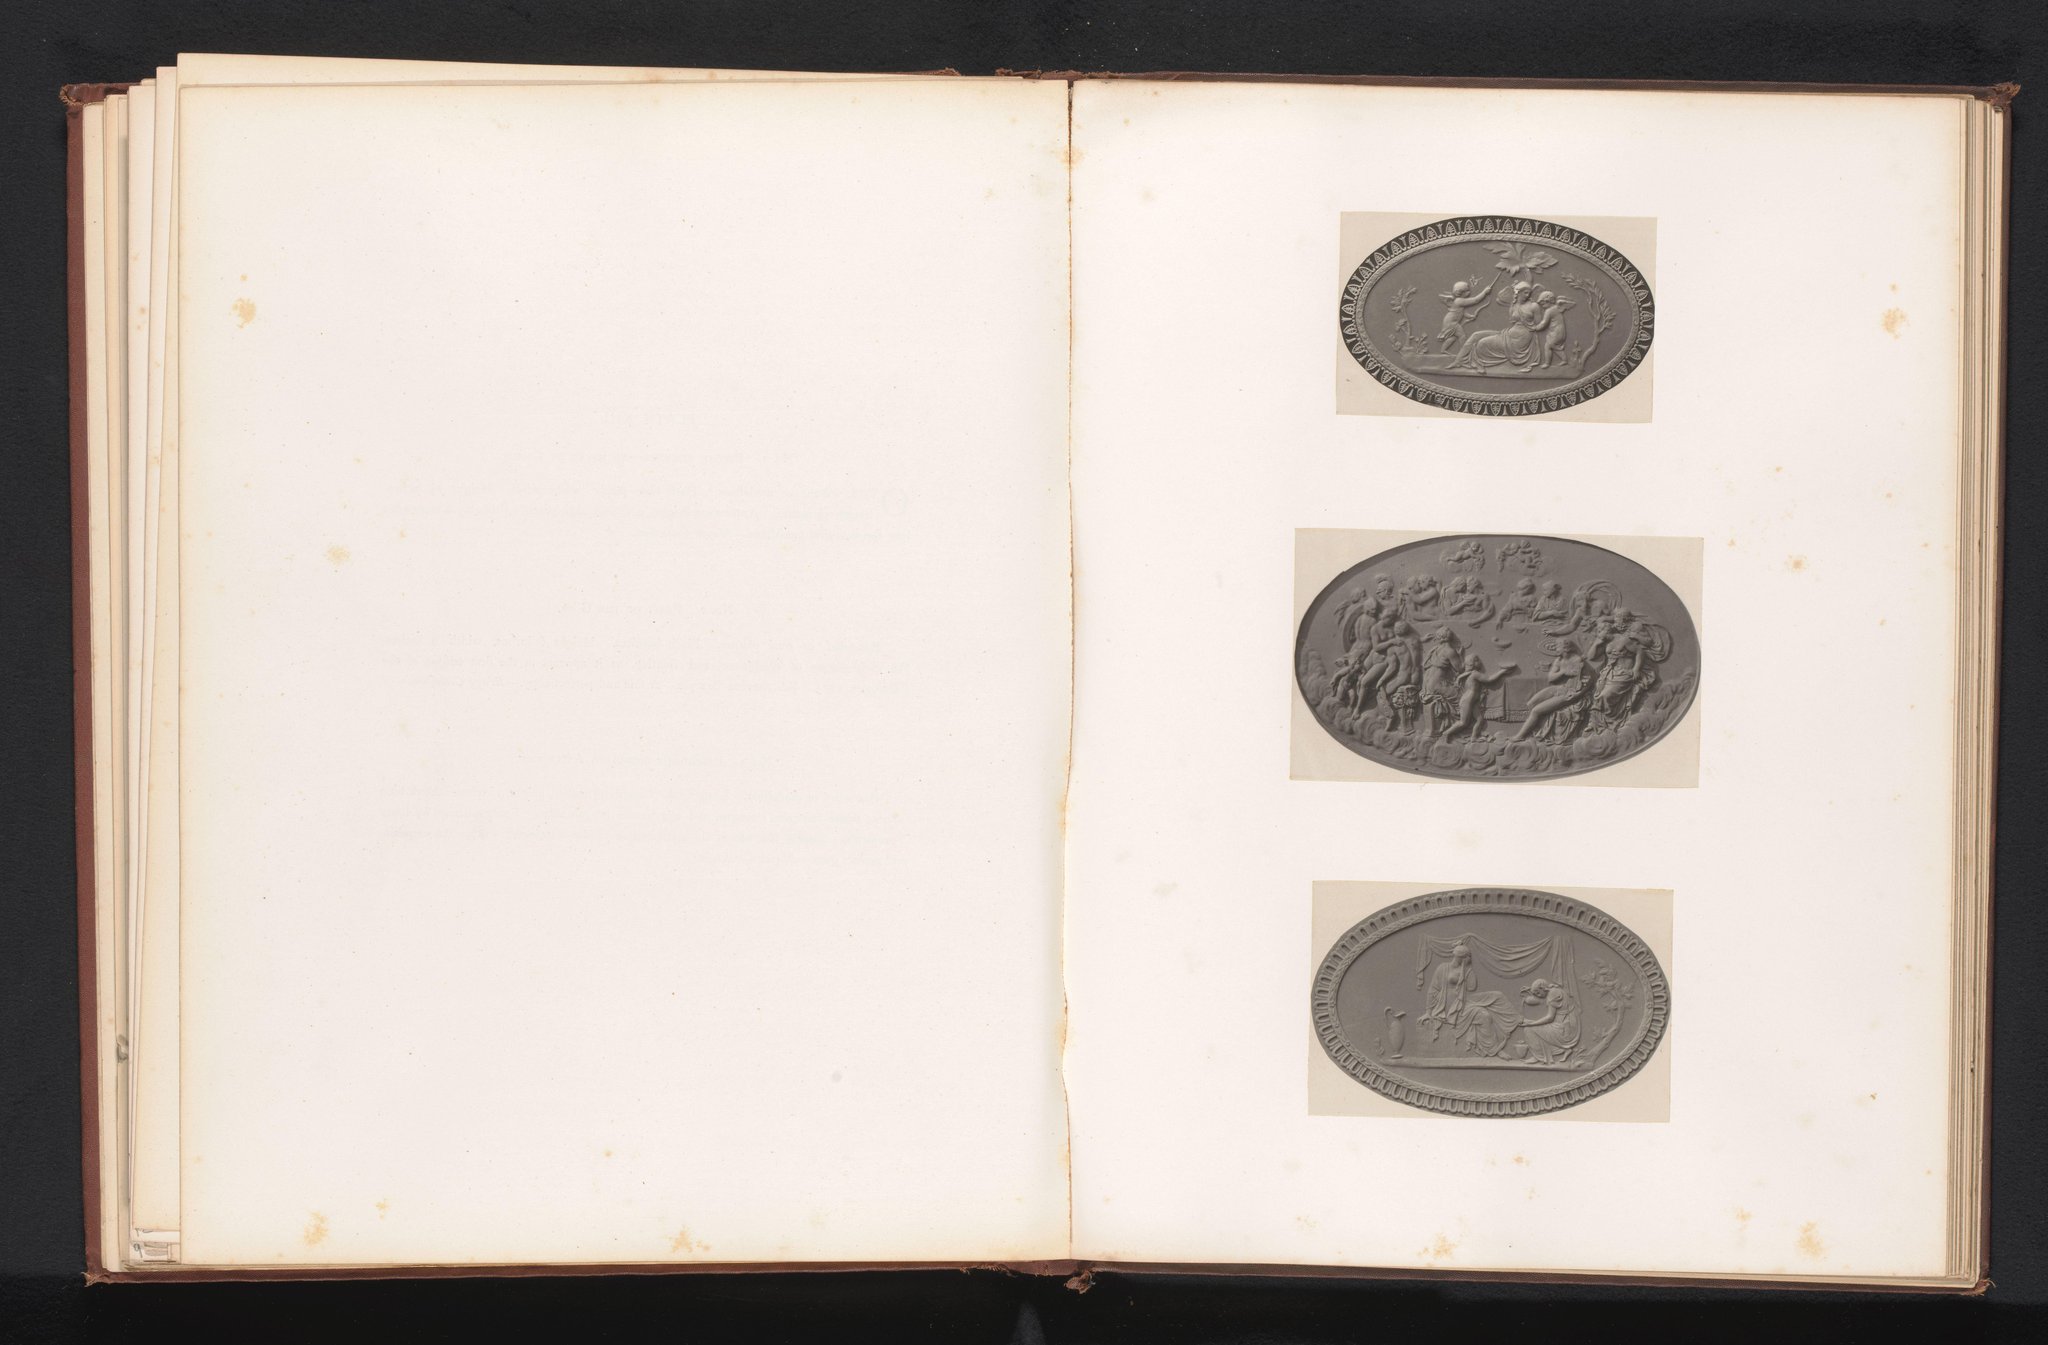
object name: page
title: Bas-reliëfs van Psyche die wordt vastgebonden door putti, een feestmaal van de goden en de vriendschap die droefenis troost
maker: joseph cundall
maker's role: fotograaf, schrijver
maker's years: 1818-1895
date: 1868-1873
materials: paper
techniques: carbon print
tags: banquets, feasts of the gods (in general), other scenes from the story of cupid and psyche (+ aggressive, unfriendly activities and relationships), friendship; 'amicitia' (ripa), sculpture (+ relief ~ sculpture)